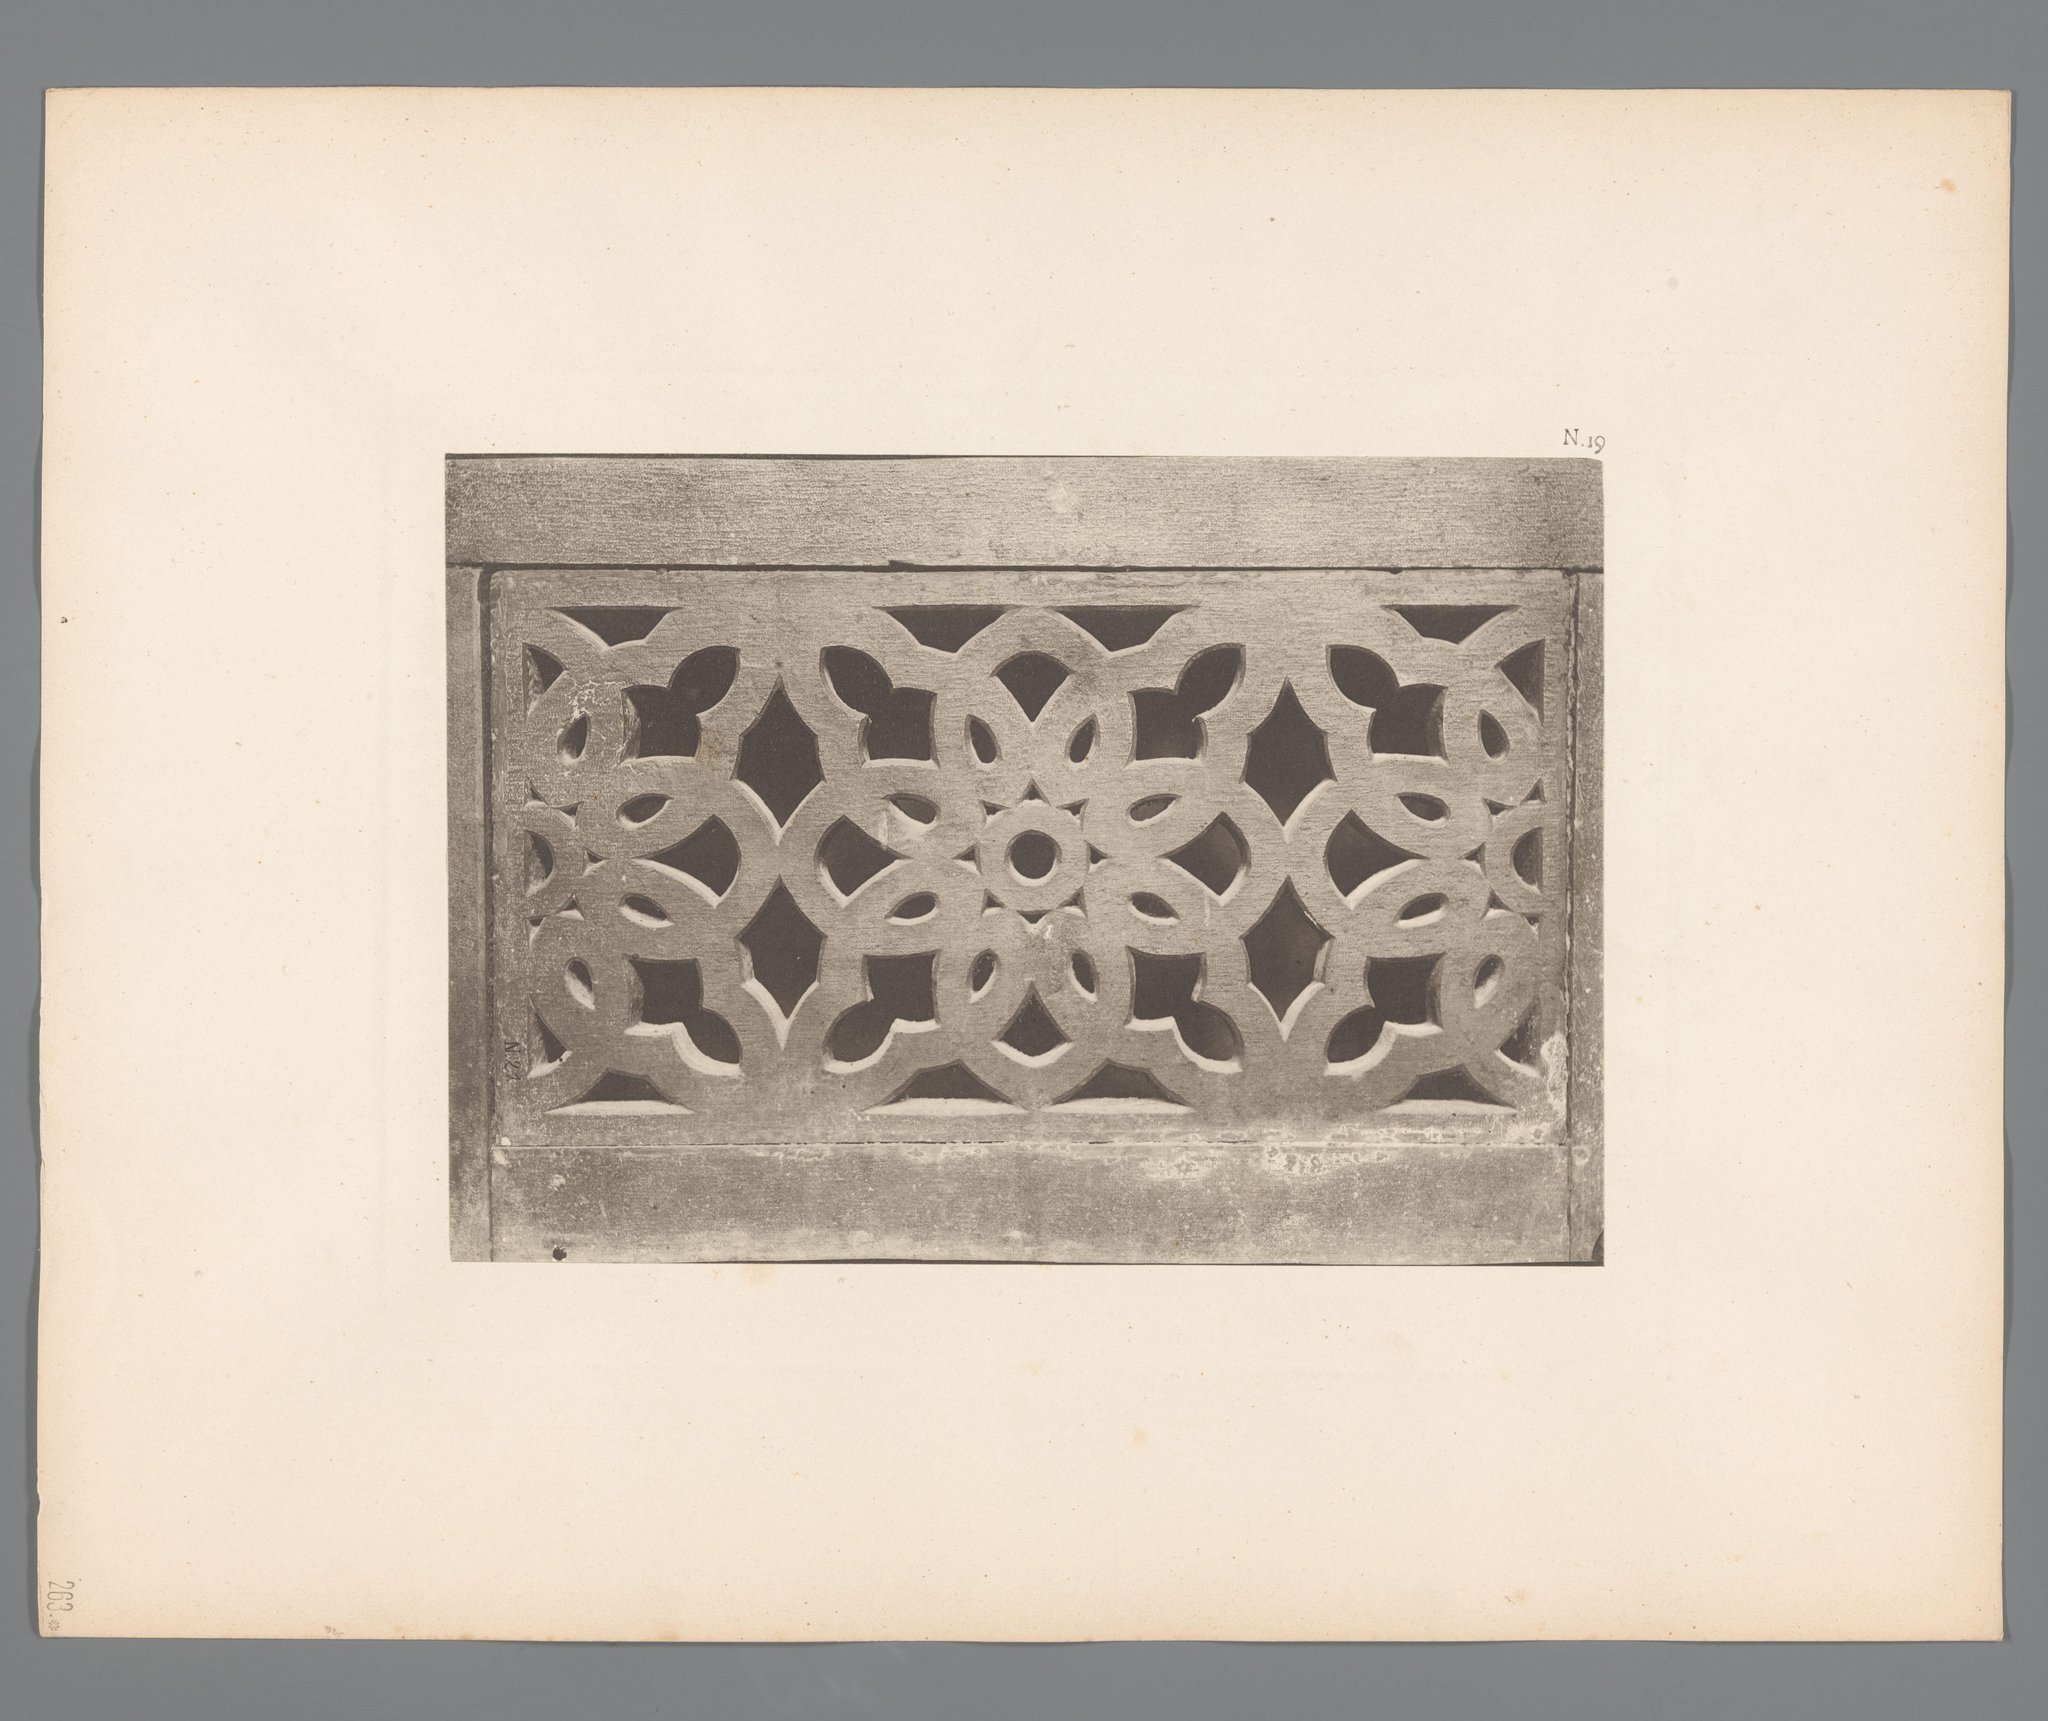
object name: photomechanical print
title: Detail van de San Marco in Venetië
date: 1880-1885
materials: paper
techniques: photograph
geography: venice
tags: piece of sculpture, reproduction of a piece of sculpture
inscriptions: number: ‘N.19’, number: ‘N.21.’, number: ‘263.*’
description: Deze prent maakt deel uit van een omslag met 58 prenten op 50 bladen.